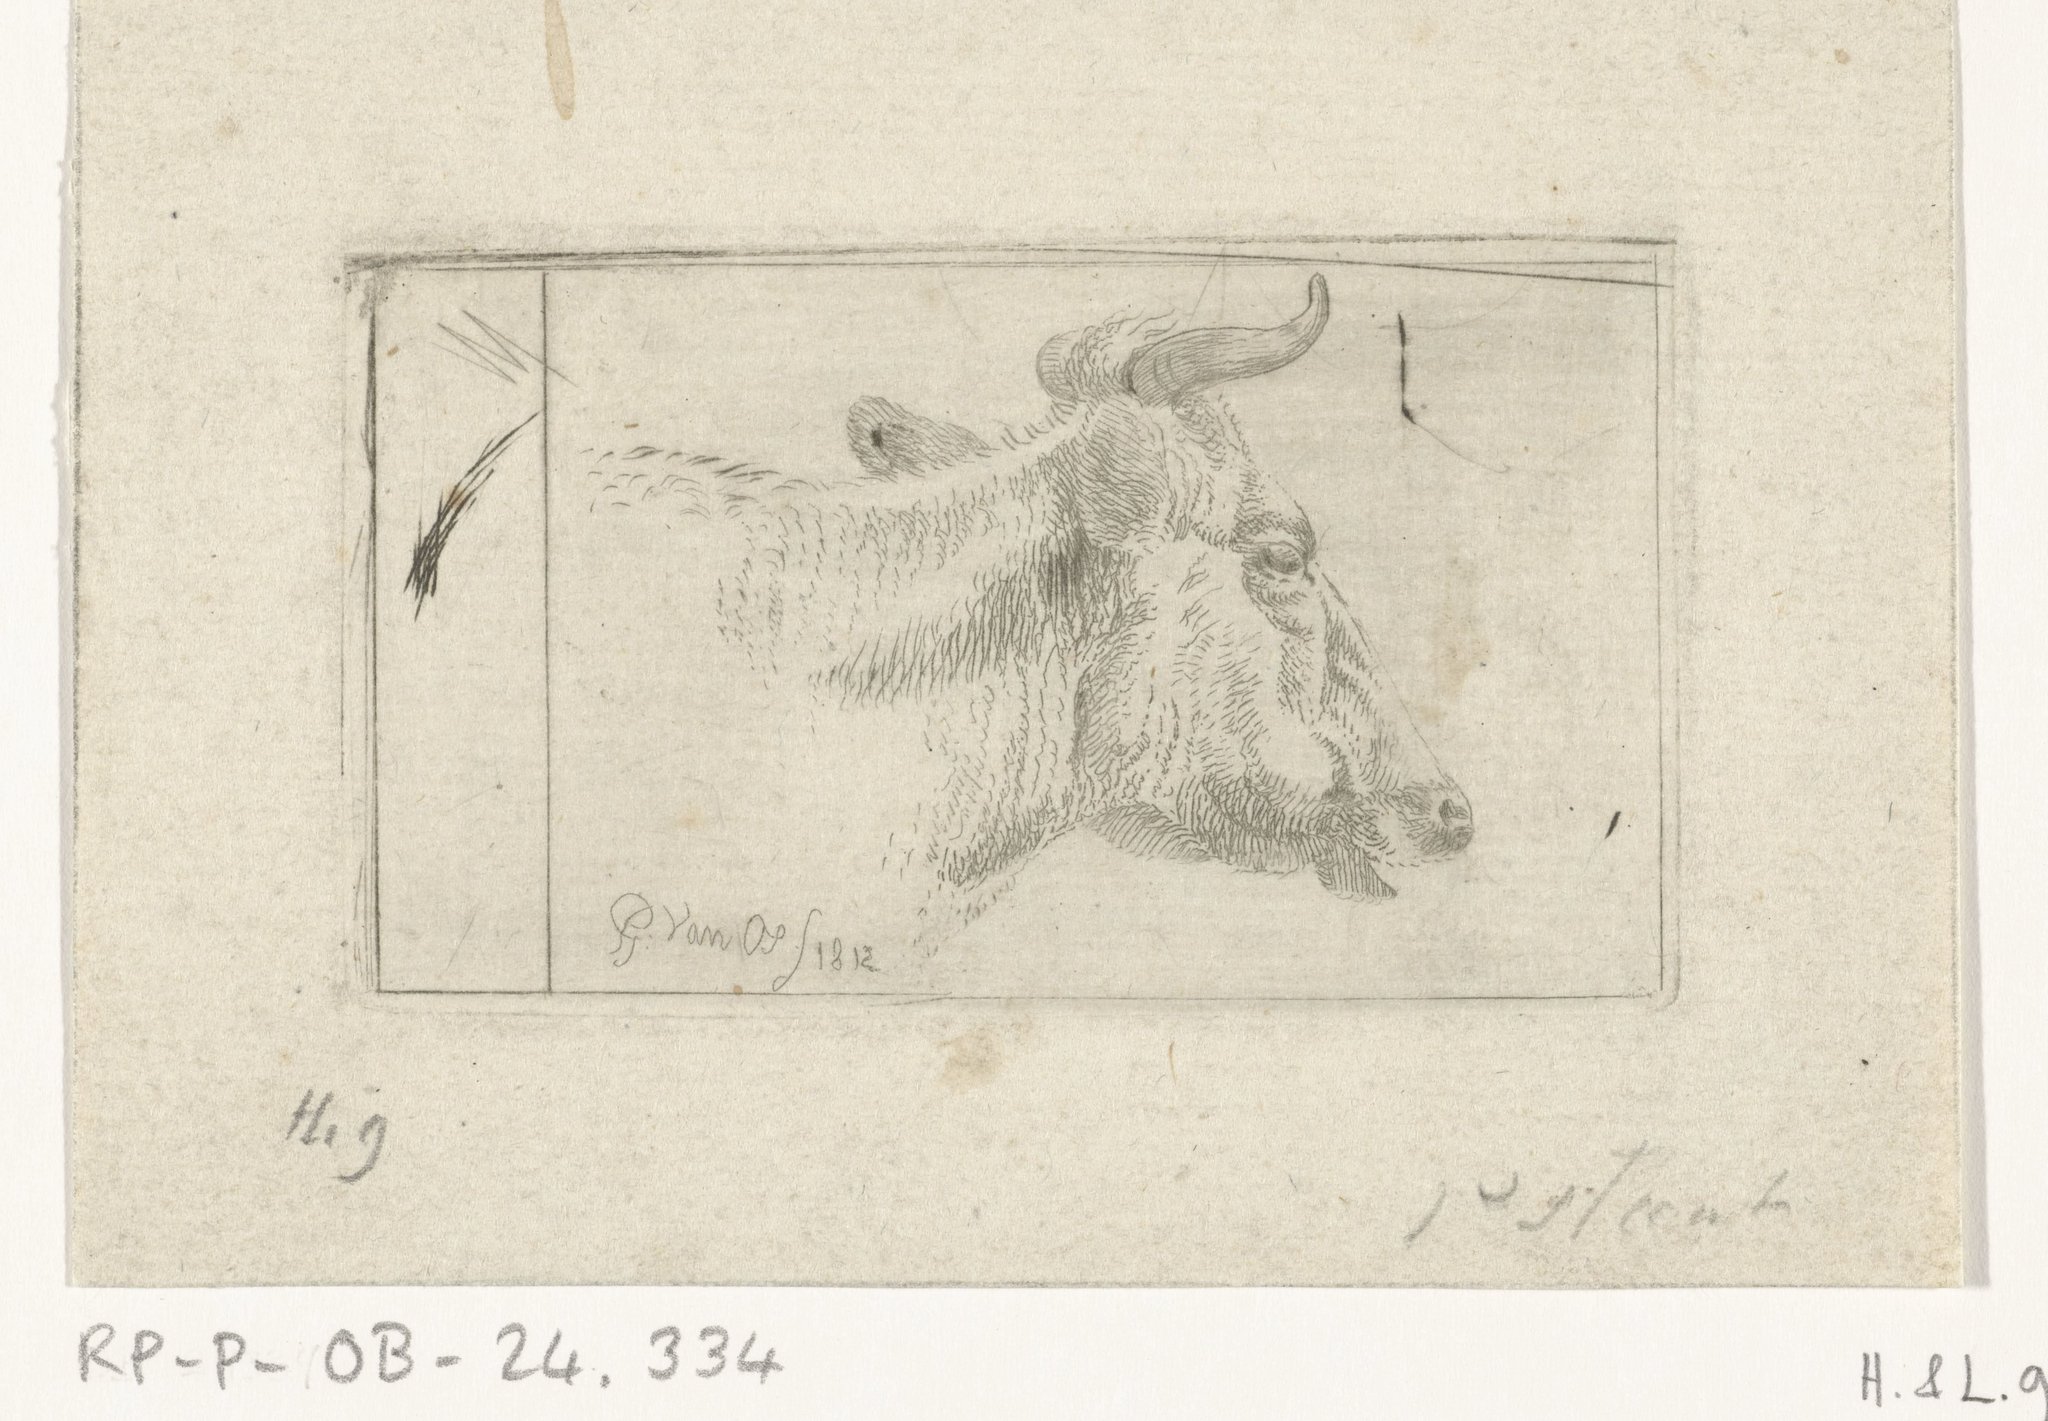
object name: print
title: Koeienkop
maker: pieter gerardus van os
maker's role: draughtsman, painter, print maker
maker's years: 1776-1839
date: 1812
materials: paper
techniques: etching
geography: netherlands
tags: cow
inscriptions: collector's mark: Lugt 2228